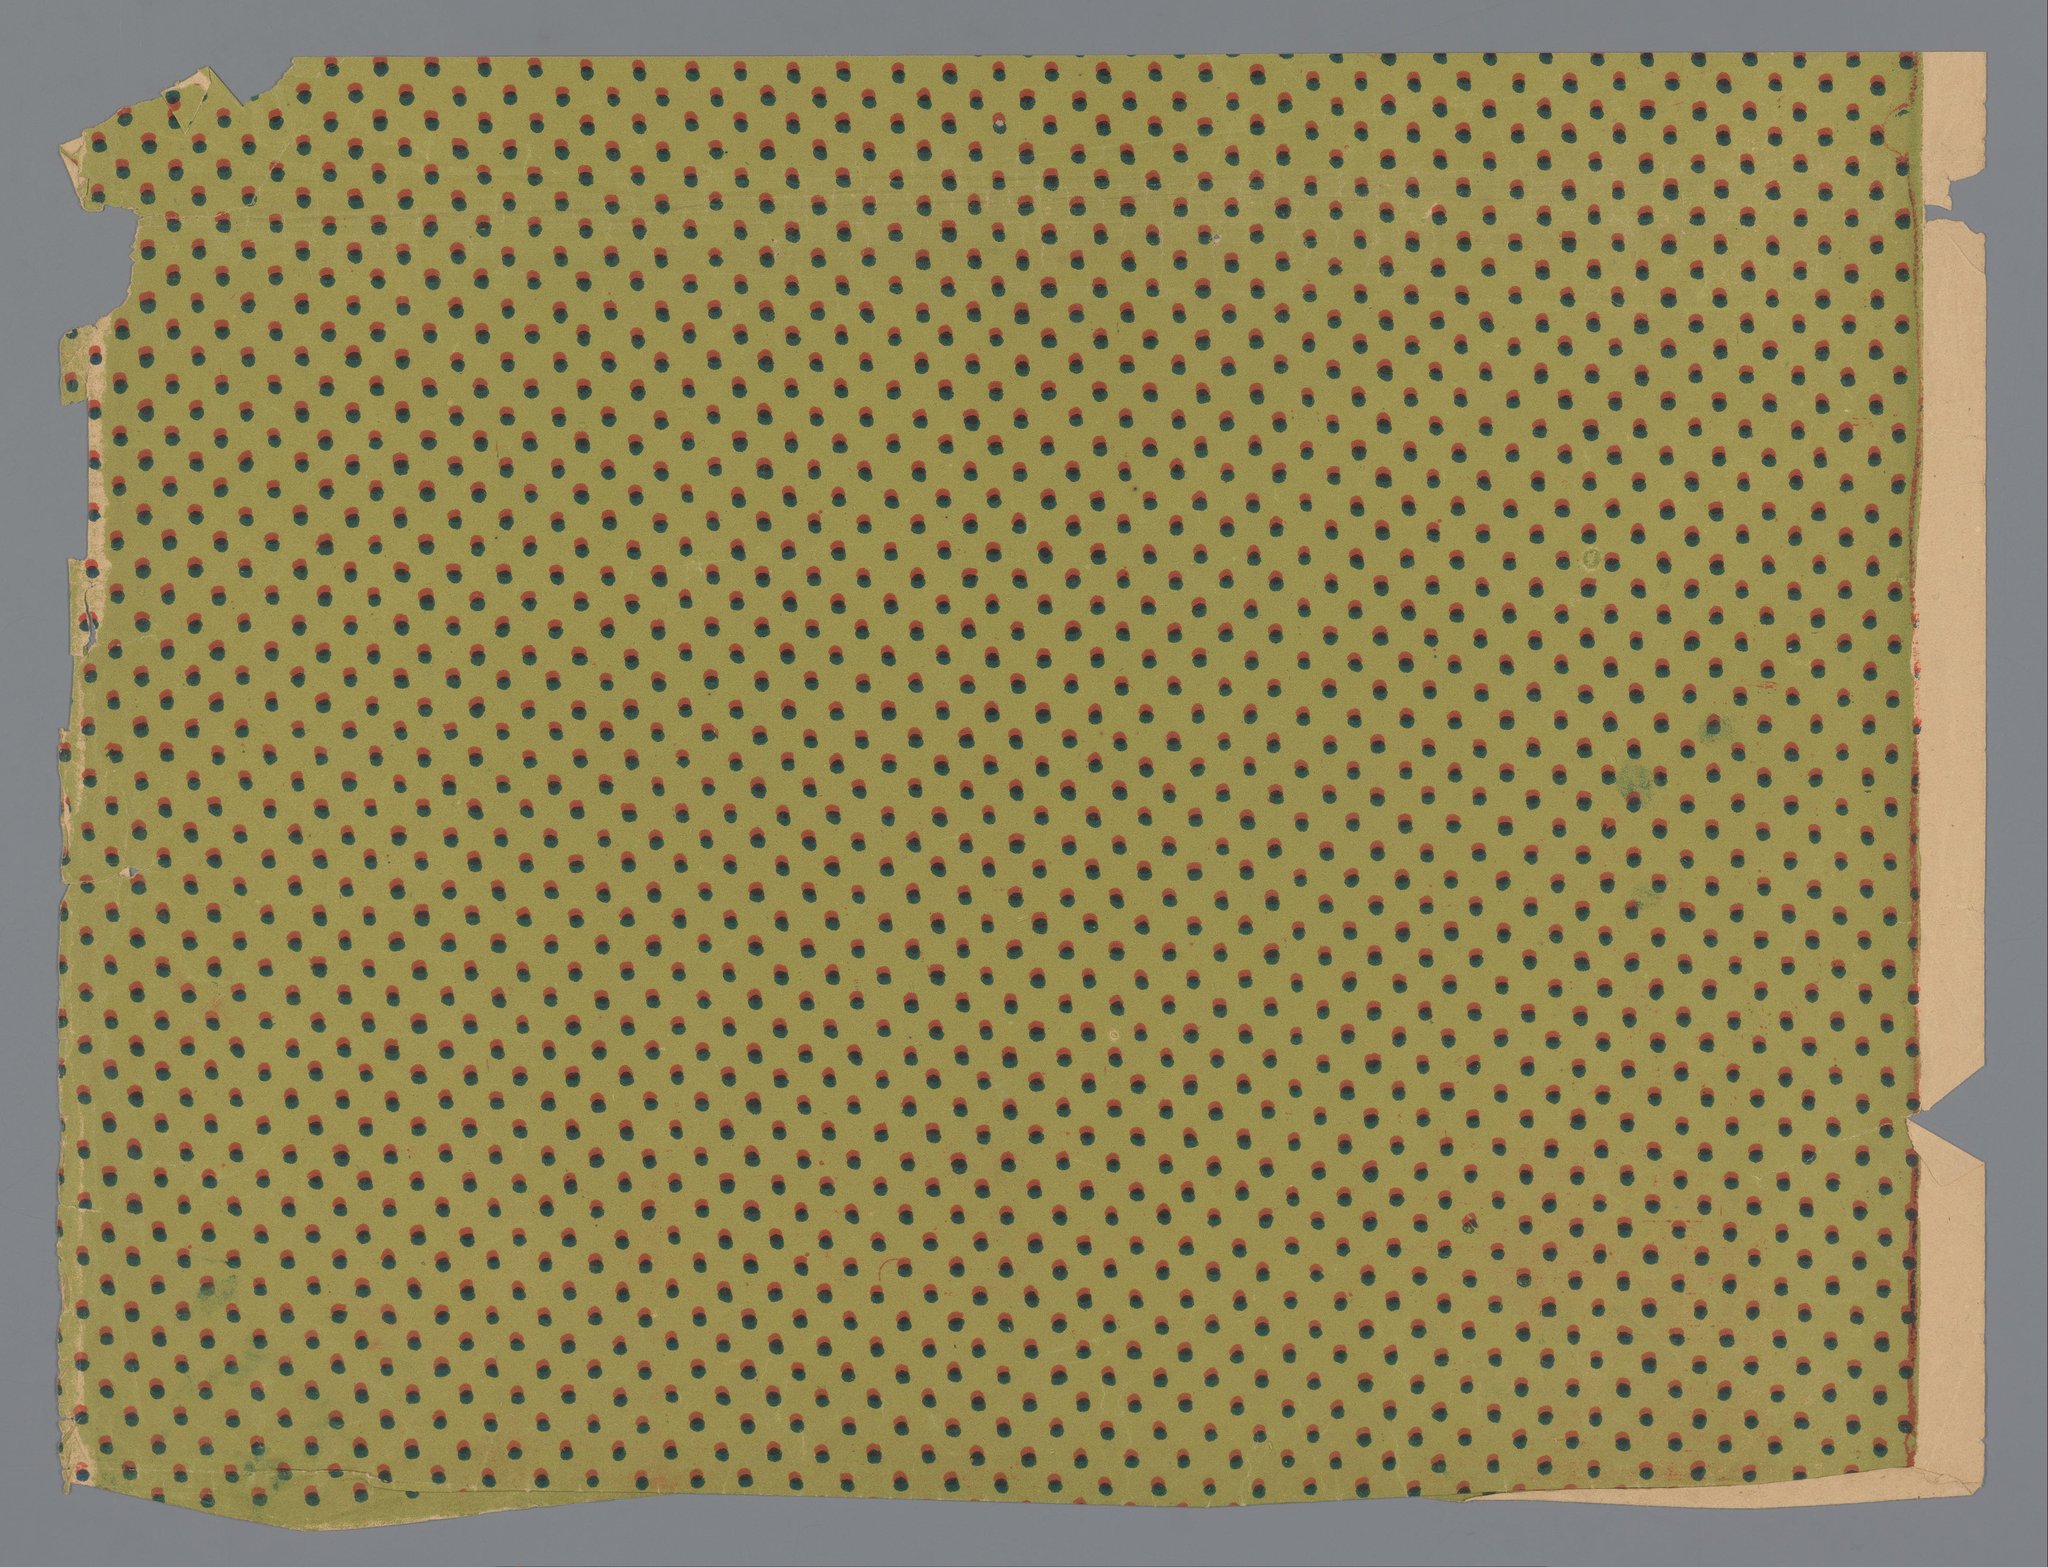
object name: printed paper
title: Blad met stippenpatroon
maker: Anonymous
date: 1850-1950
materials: paper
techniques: printing block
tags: ornament ~ geometric motifs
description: Blad met patroon van twee deels overlappende stippen.